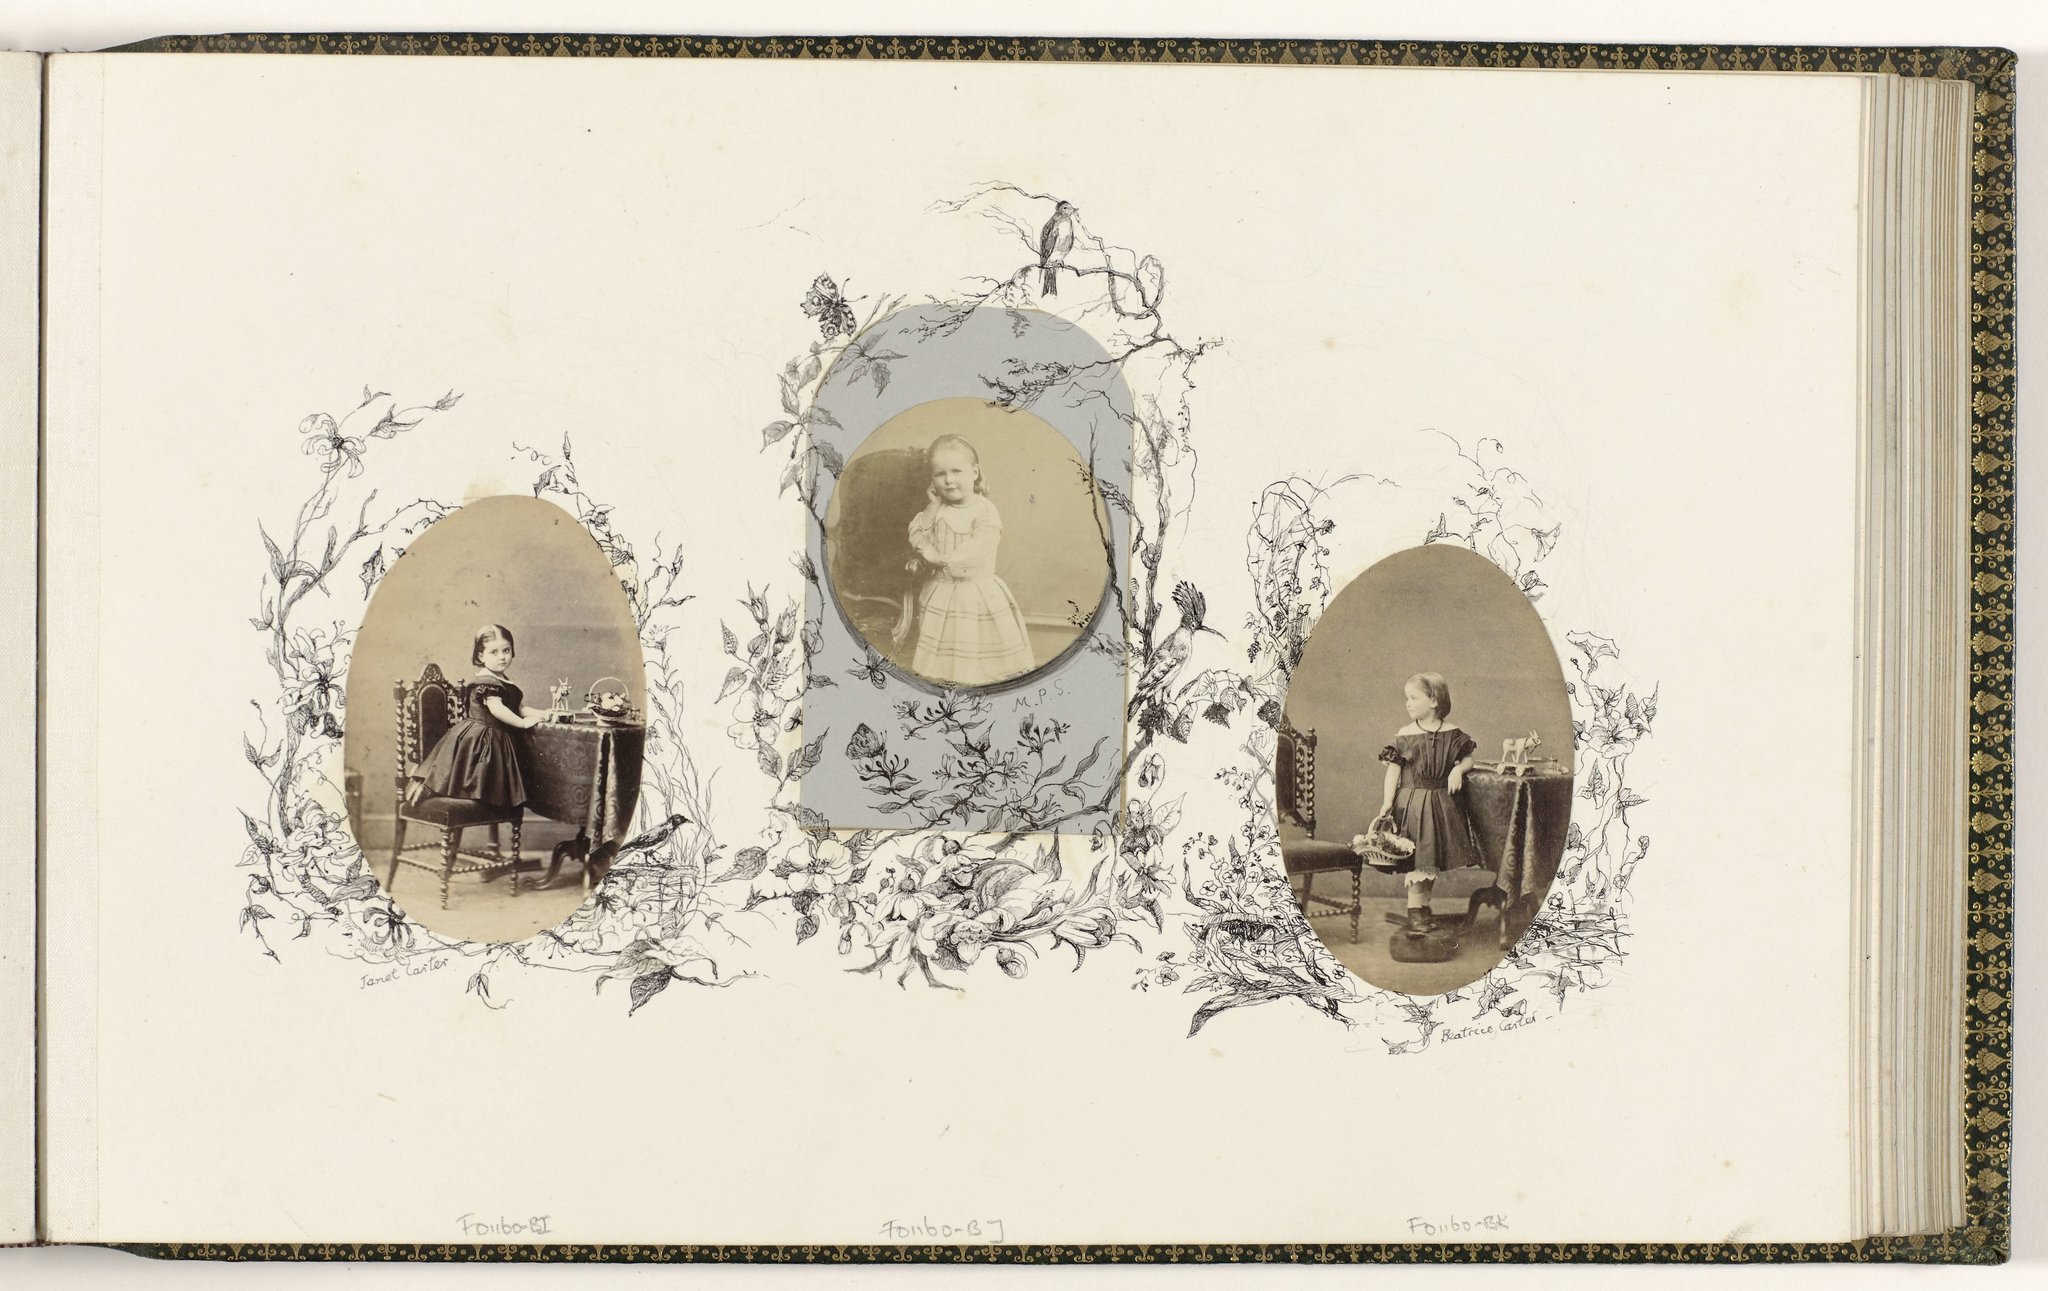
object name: album leaf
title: Portret van een meisje, aangeduid als M.P.S.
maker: Anonymous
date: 1865-1880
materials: paper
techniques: albumen print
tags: historical persons, girl (child between toddler and youth)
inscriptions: inscription: ‘M.P.S.’